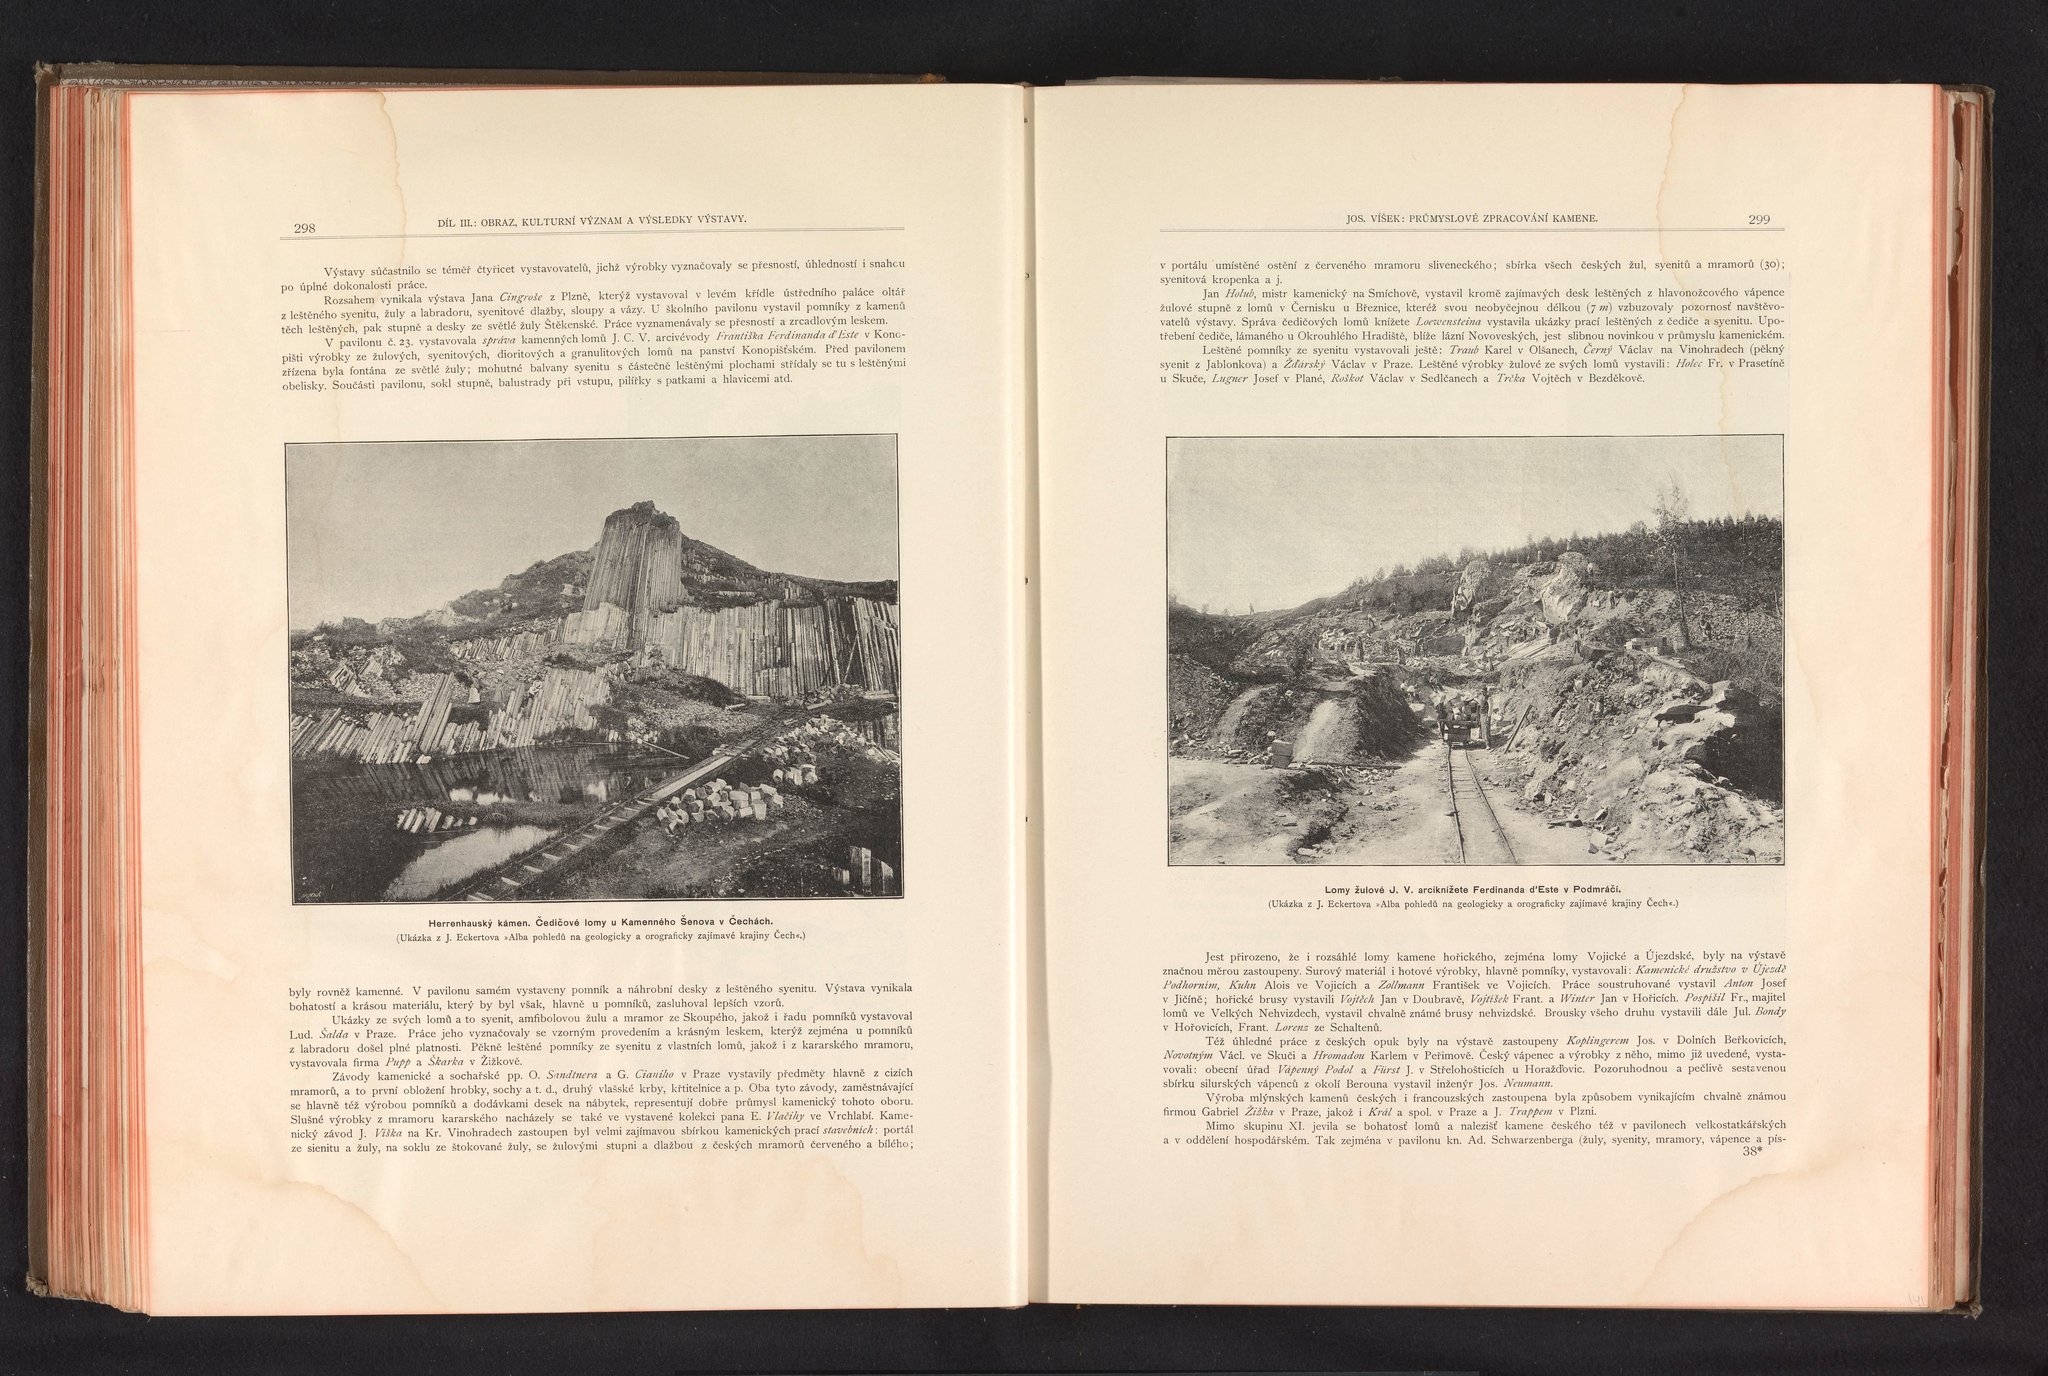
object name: photomechanical print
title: Herrenhauský kámen. Cedicové lomy u Kamenného Senova v Cechách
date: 1890-1895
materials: paper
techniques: autotype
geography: prague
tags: quarry